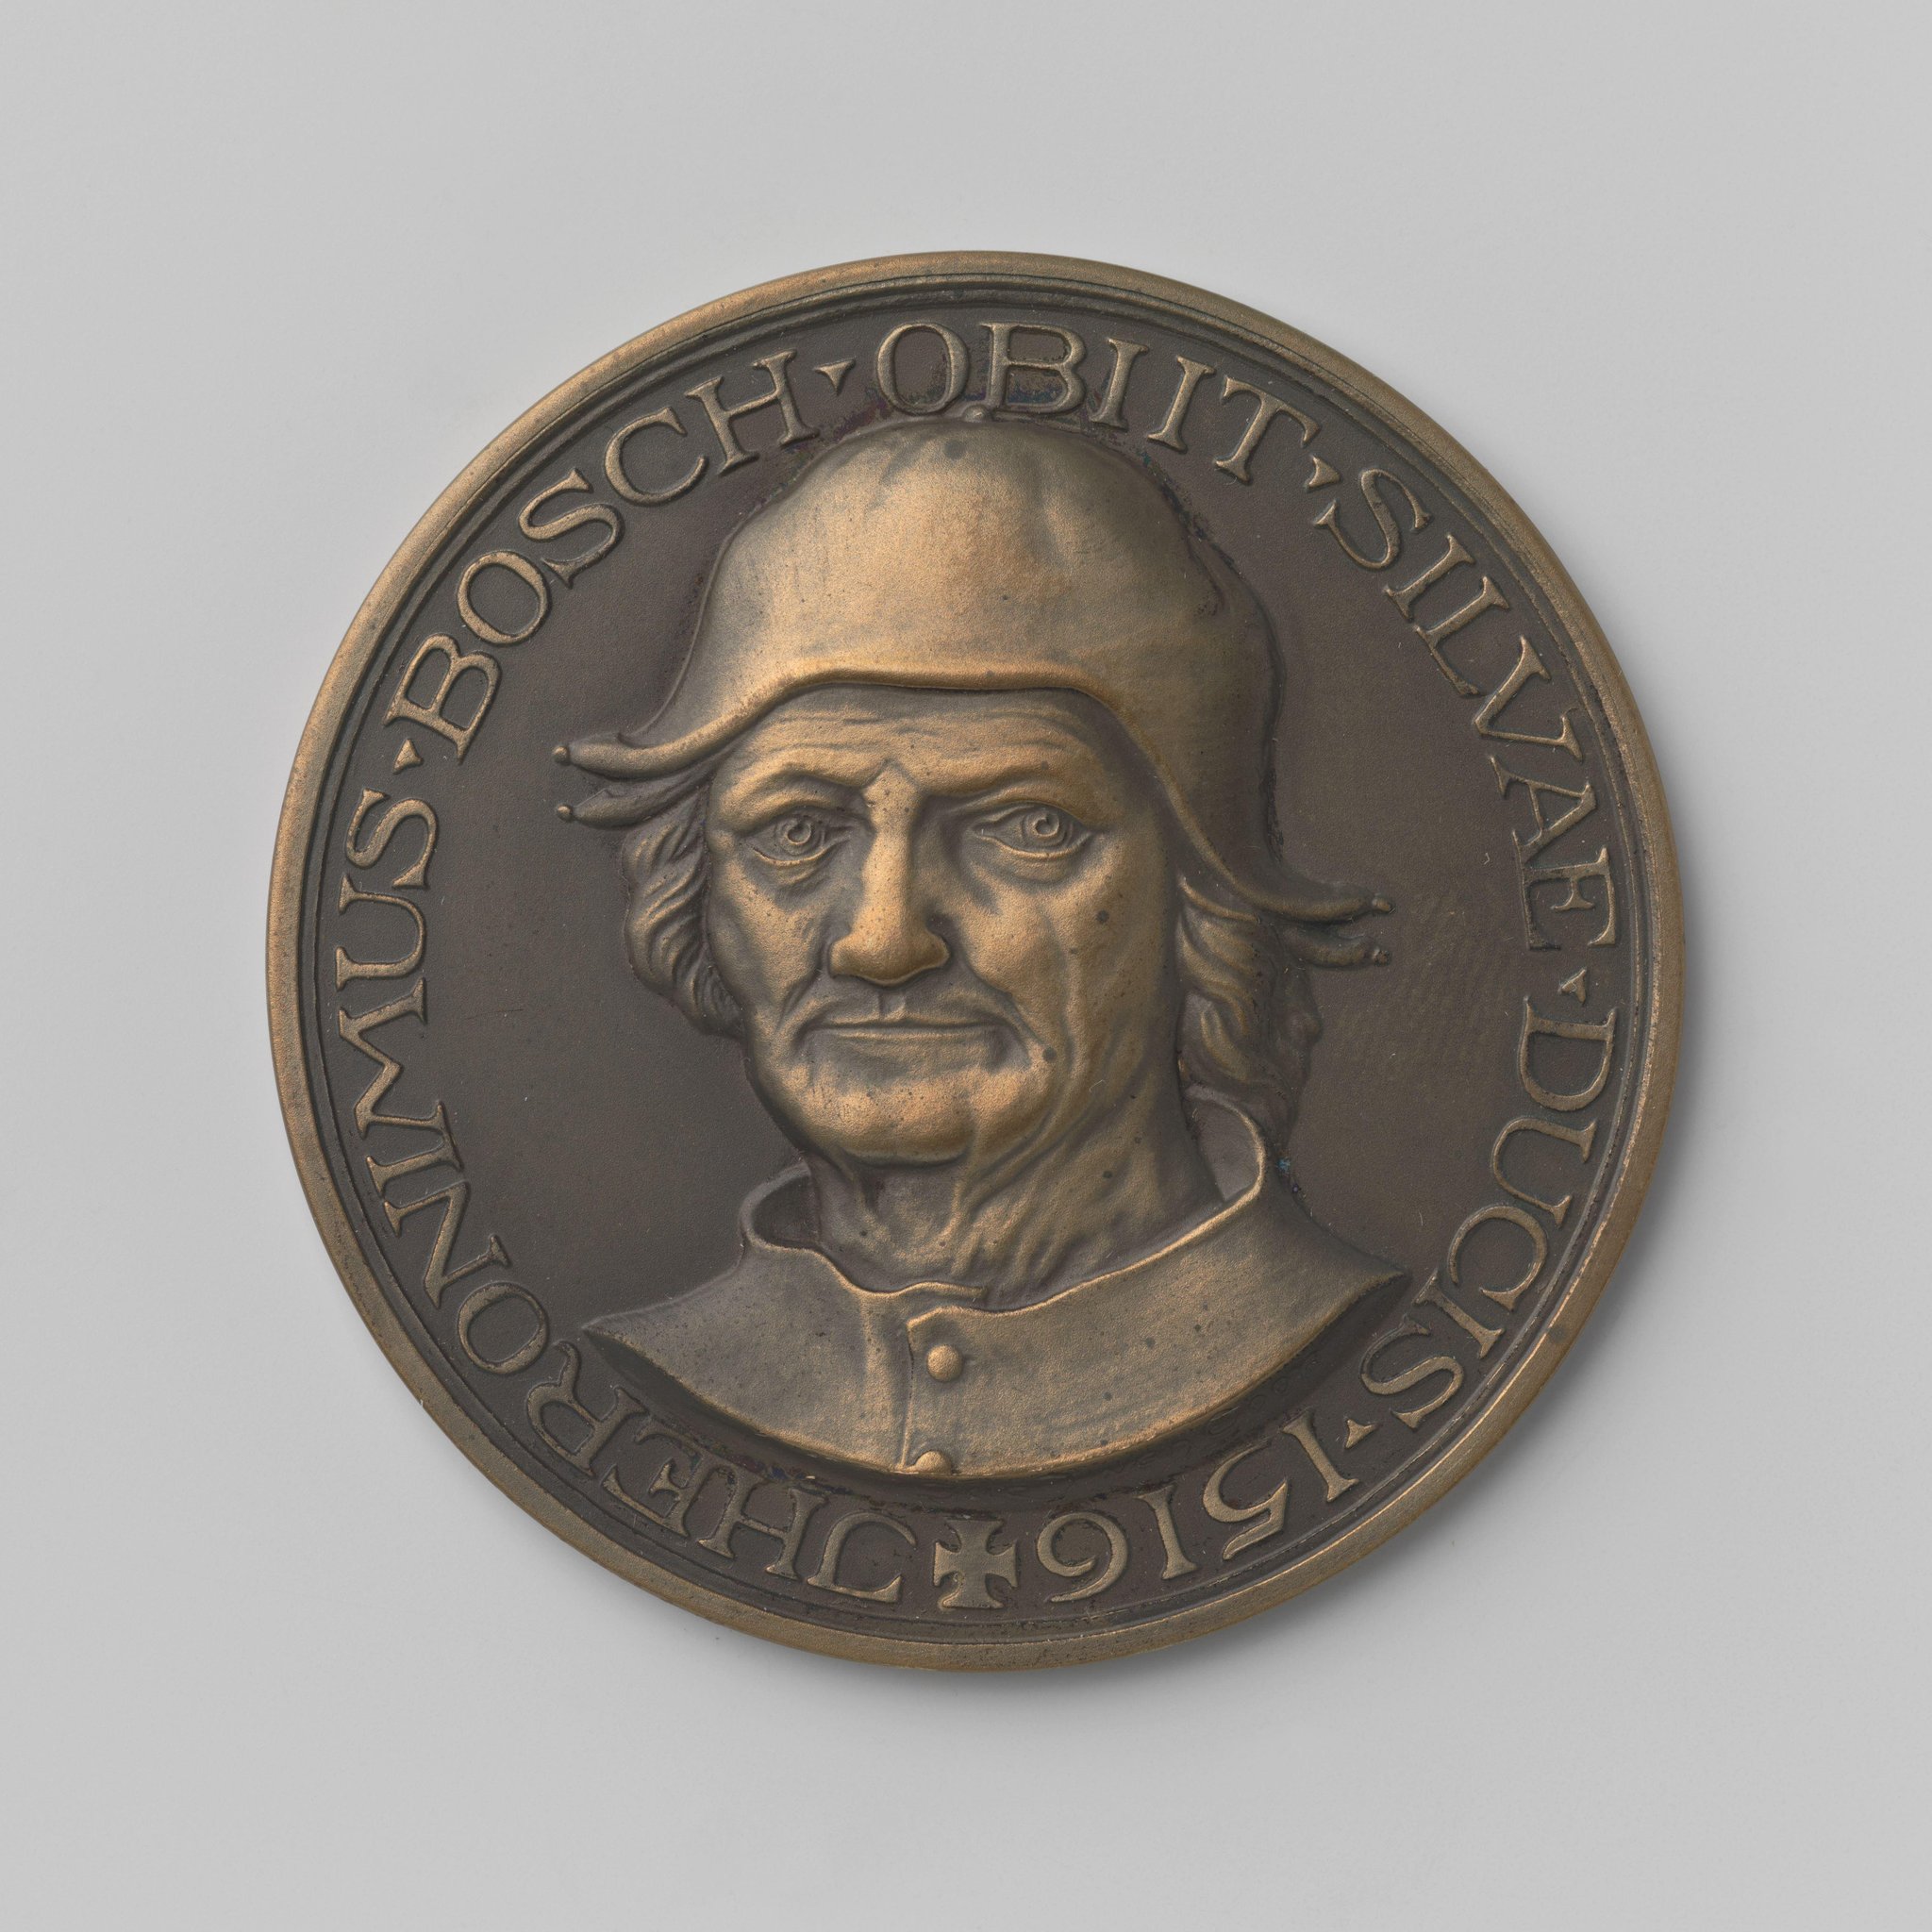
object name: history medal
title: Onthulling van het standbeeld van Jeroen Bosch te 's-Hertogenbosch 1930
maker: jacob jan van goor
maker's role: medailleur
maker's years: 1874-1956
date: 1929-1930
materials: bronze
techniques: striking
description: Bronzen penning, op de voorzijde het bijna aanziende borstbeeld van Bosch met omschrift, op de keerzijde het wapenschild van 's-Hertogenbosch op een kort gelelied kruis met omschrift.